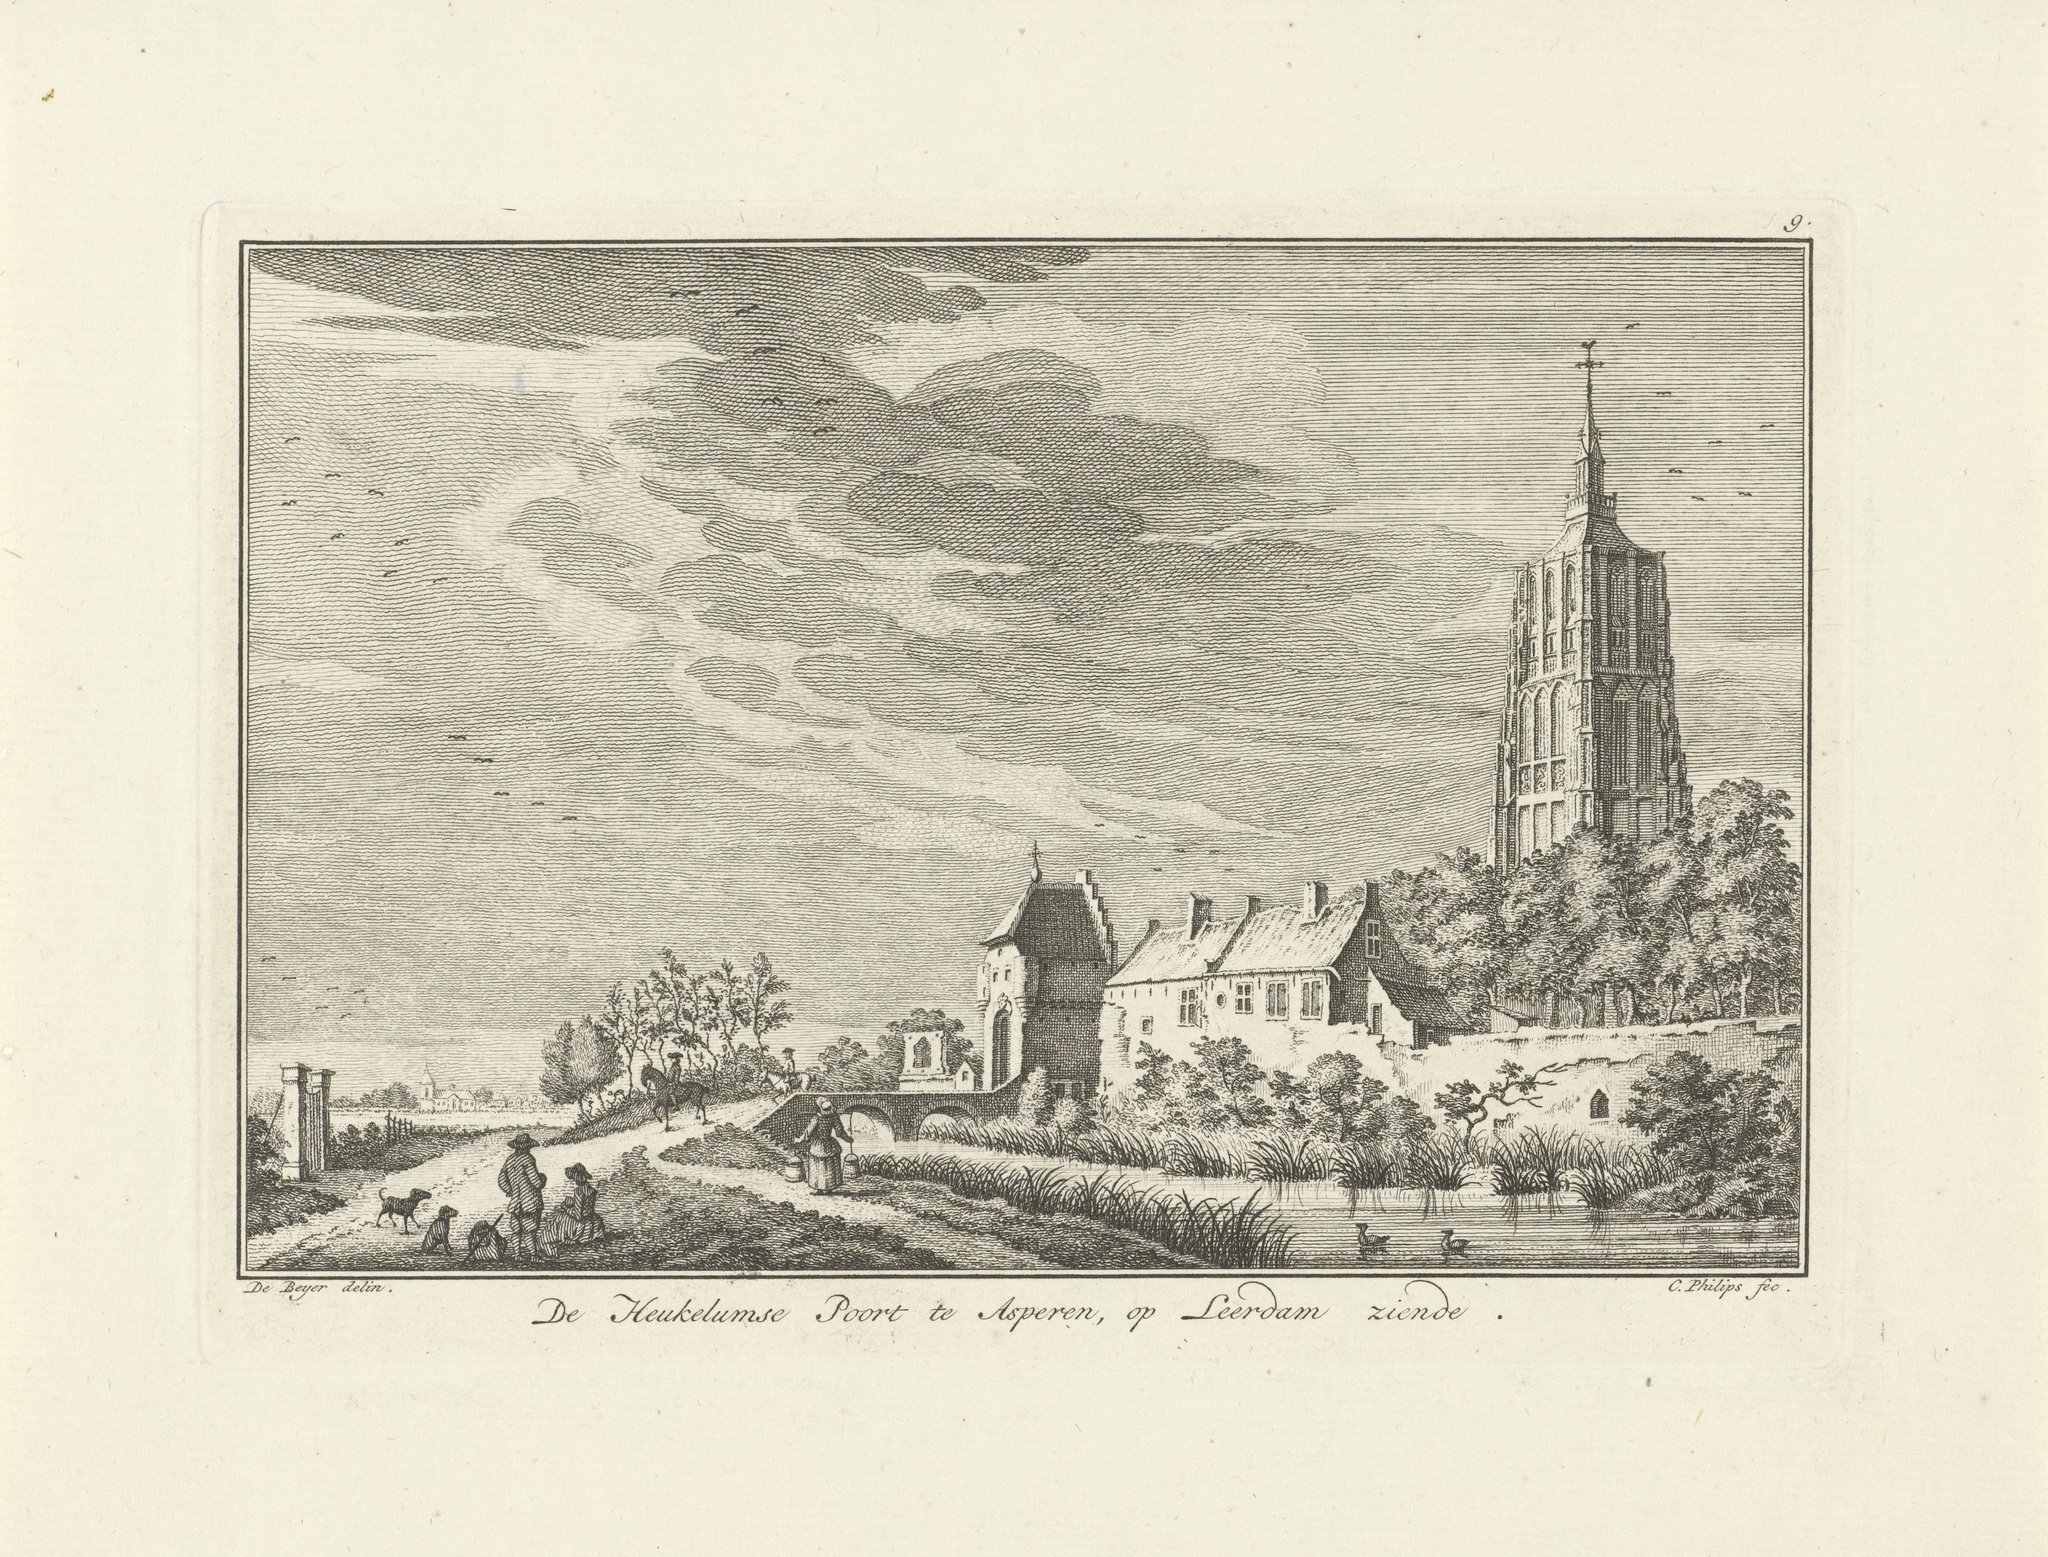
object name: print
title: Gezicht op de Heukelumse Poort te Asperen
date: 1758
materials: paper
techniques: etching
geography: amsterdam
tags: city-view in general; 'veduta', church (exterior), city-gate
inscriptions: collector's mark: Lugt 2228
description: Mogelijk onderdeel van een prentserie. Voor eerdere staat zie RP-P-1888-A-13952. Zie RP-T-1888-A-1653 voor de tekening waar deze prent op is gebaseerd.